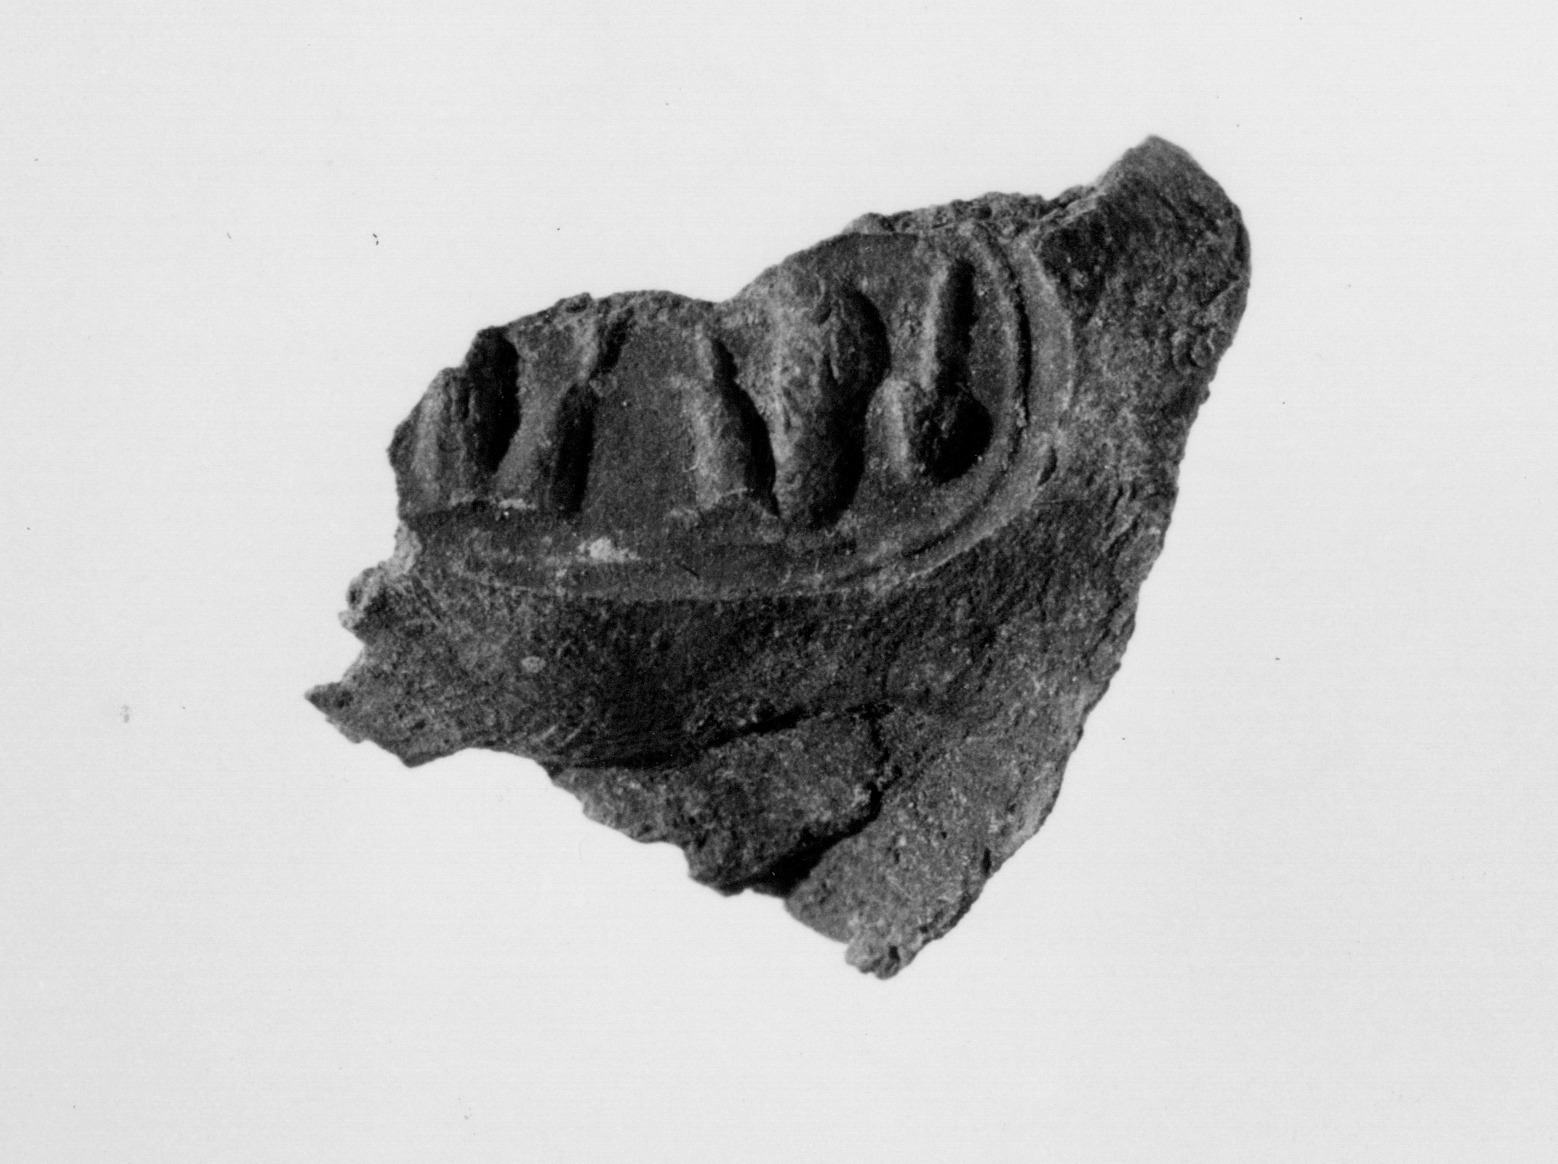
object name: sealing, nebmaatre, amenhotep iii, horus, re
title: Document Sealing With the Throne Name of Amenhotep III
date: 1390-1352 BCE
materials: mud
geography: egypt